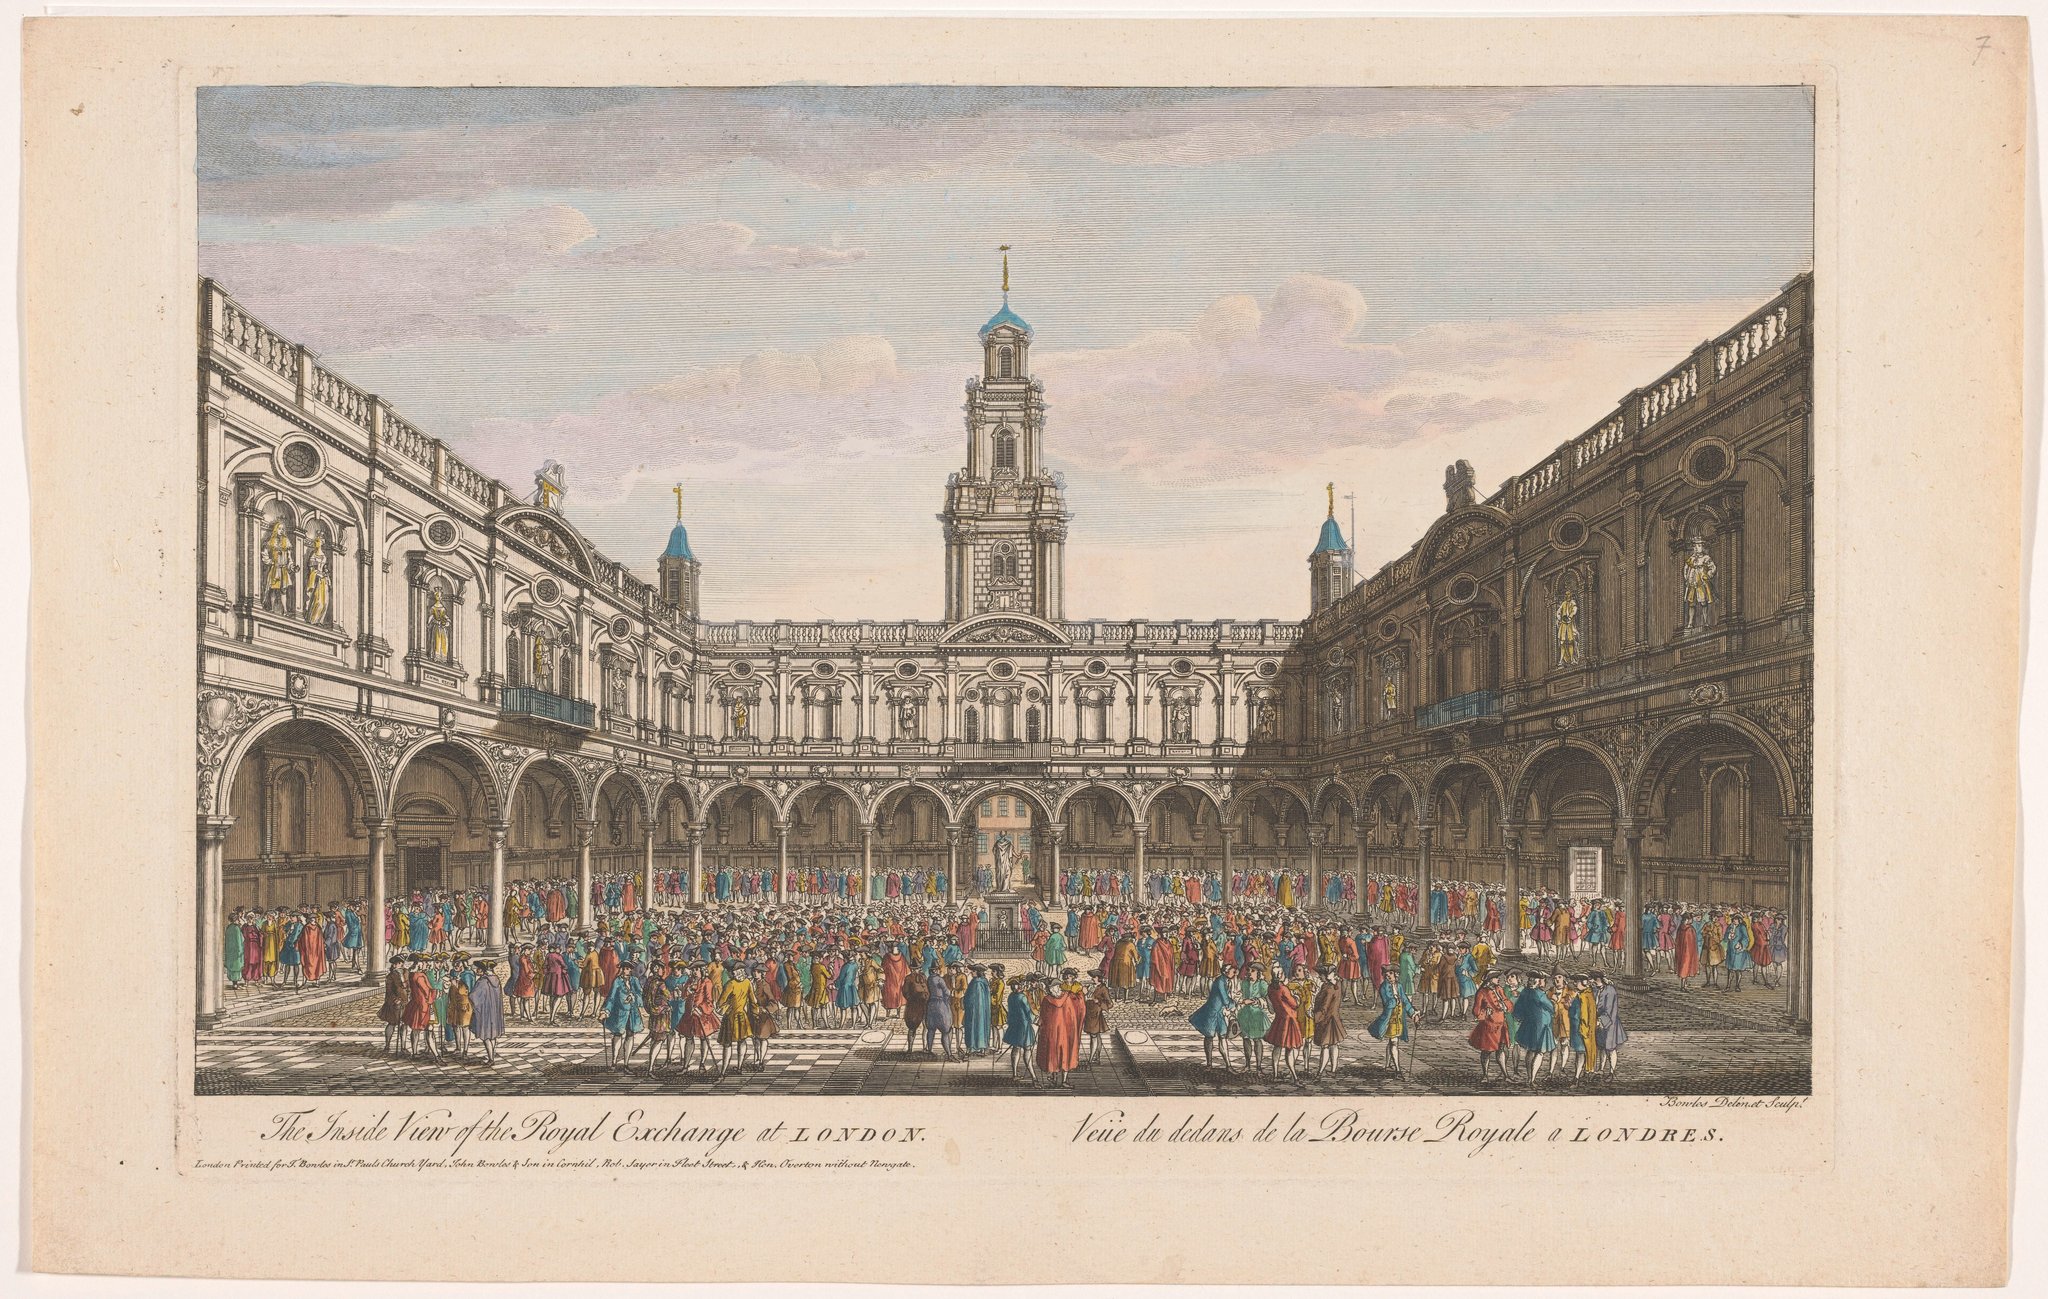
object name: print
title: Londen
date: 1745-1753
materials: paper, watercolor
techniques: brush, etching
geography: london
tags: stock exchange, stock-market, interior ~ representation of a building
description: De serie “Londen” bevat 52 prenten met de nummers 1-52, waarvan dit nummer 7 is.